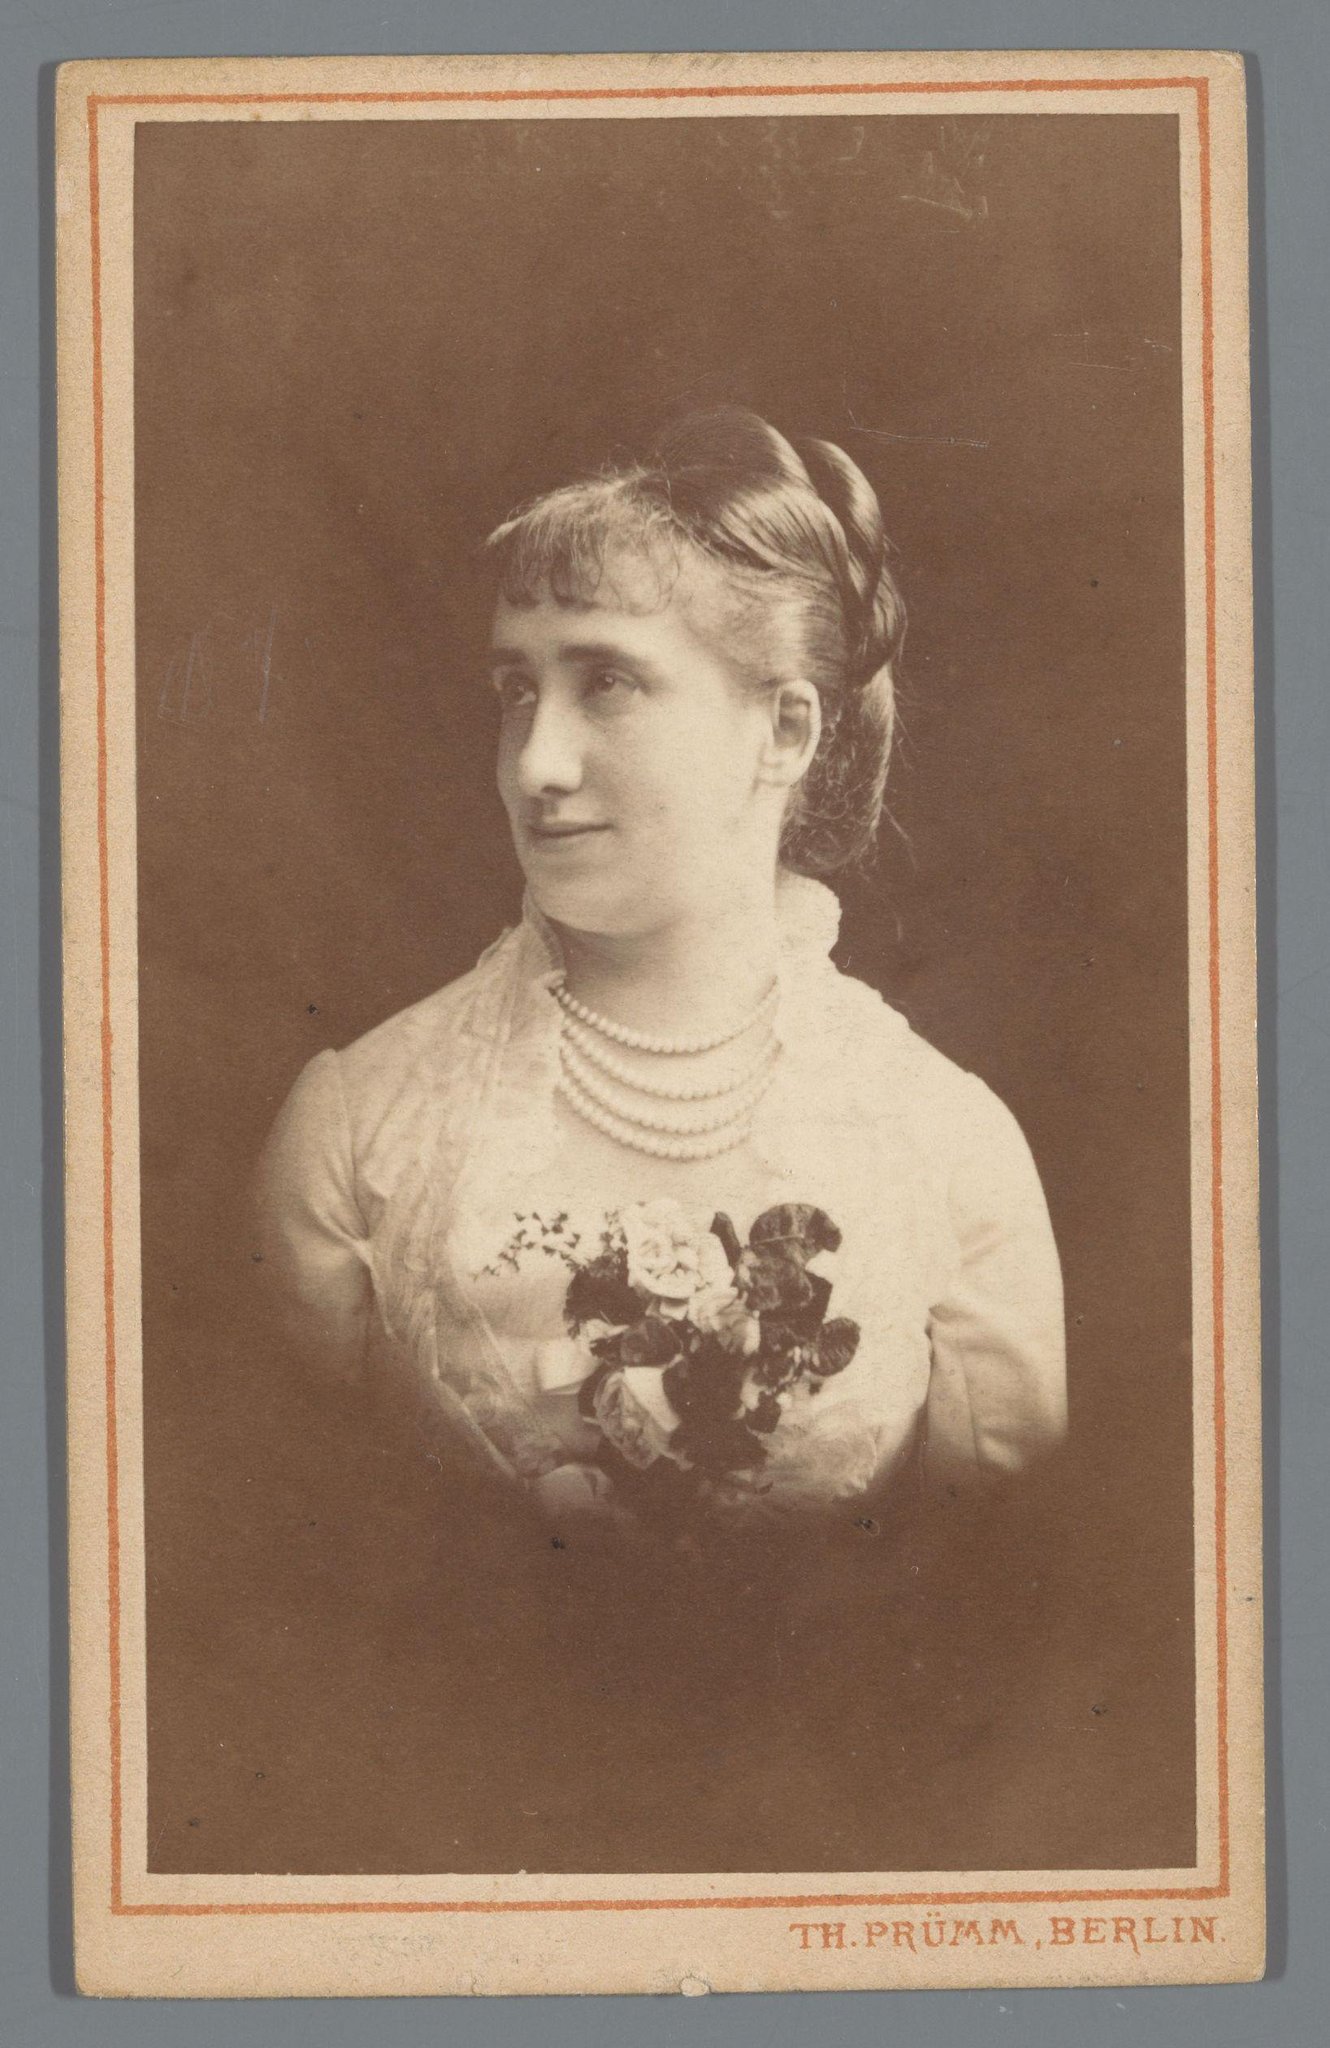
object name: carte de visite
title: Portret van een onbekende jonge vrouw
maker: theodor prümm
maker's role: fotograaf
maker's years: 1841-1890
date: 1877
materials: cardboard, paper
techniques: albumen print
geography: berlin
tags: adolescent, young woman, maiden, anonymous historical person portrayed, berlin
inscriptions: inscription: ‘Inhaber der Preismedaillen/ Wien 1873/ Berlin 1865/ Hamburg 1868/ Theodor Prümm/ Berlin/ Unter den Linden 51./ 1877/ Platten werden aufbewahrt.’, inscription: ‘Th. Prümm, Berlin.’